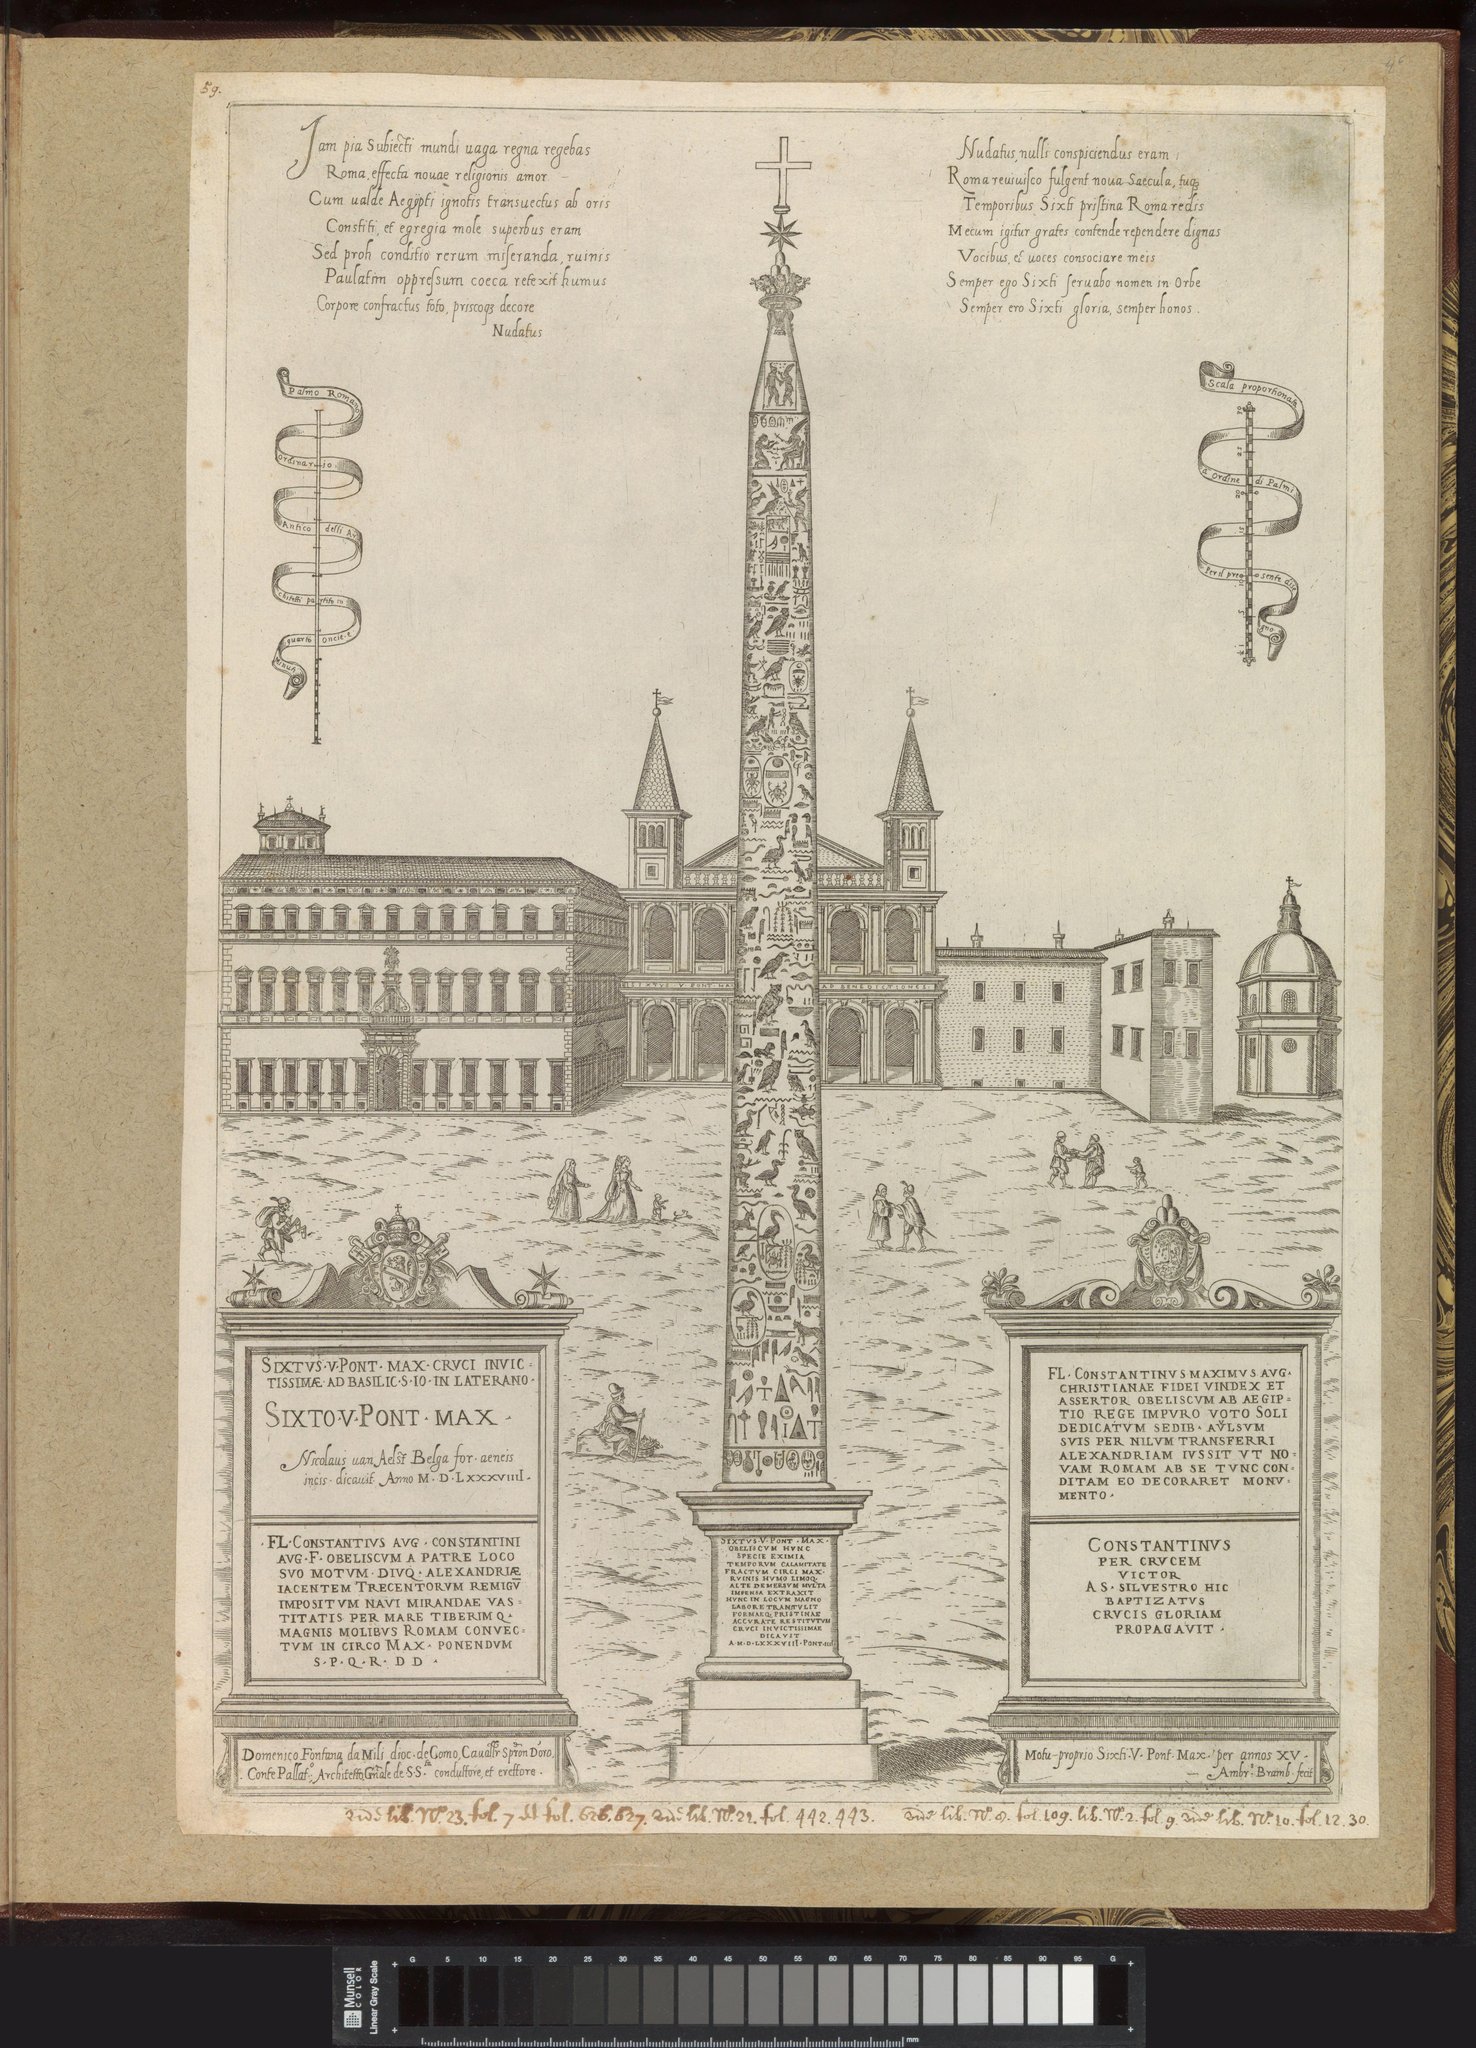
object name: album leaf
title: Lateraanse Obelisk op Piazza di San Giovanni in Laterano te Rome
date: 1589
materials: paper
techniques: engraving, etching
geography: italy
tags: obelisk, needle, church (exterior), city-gate, rome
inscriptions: number: ‘59’, inscription: ‘Ende lib. No. 23. fol. 7 [...] fol. 626. 627. Ende lib. No. 22. fol. 442. 443./ Ende lib. No. 8. fol. 109. lib. No. 2. fol. 9. Ende lib. No. 10. fol. 12. 30.’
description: Deze prent behoort tot het prentcorpus dat bekend staat als de ‘Speculum Romanae Magnificentiae’ (‘Spiegel van Romeinse pracht’). Dit corpus, bestaande uit prenten met voorstellingen van kunstwerken en gebouwen uit het antieke en het moderne Rome, vond zijn oorsprong bij uitgevers Antonio Salamanca en Antonio Lafreri. Deze twee buitenlandse uitgevers bundelden hun krachten te Rome in de periode 1553-1563. Hun prenten werden al snel razend populair bij toeristen en verzamelaars, die de prenten individueel of in grote groepen aanschaften. Grote groepen Speculum-prenten werden vaak op aanvraag samengebonden in albums. Er zijn verschillende Speculum-albums overgeleverd die allemaal verschillen van inhoud. Tussen 1573 en 1577 gaf Antonio Lafreri een speciale titelpagina uit (met de titel ‘Speculum Romanae Magnificentiae’) die mensen voor hun verzamelingen konden voegen. Het overlijden van Lafreri in 1577 betekende niet het einde van het corpus. Een groot deel van de koperplaten ging over op Claudio en Stefano Duchetti. De rest raakte verspreid over verschillende andere uitgevers. De populariteit van de Speculum-prenten wist nog geruime periode uitgevers te inspireren tot het laten maken van kopieën en het toevoegen van nieuwe prenten aan het corpus.